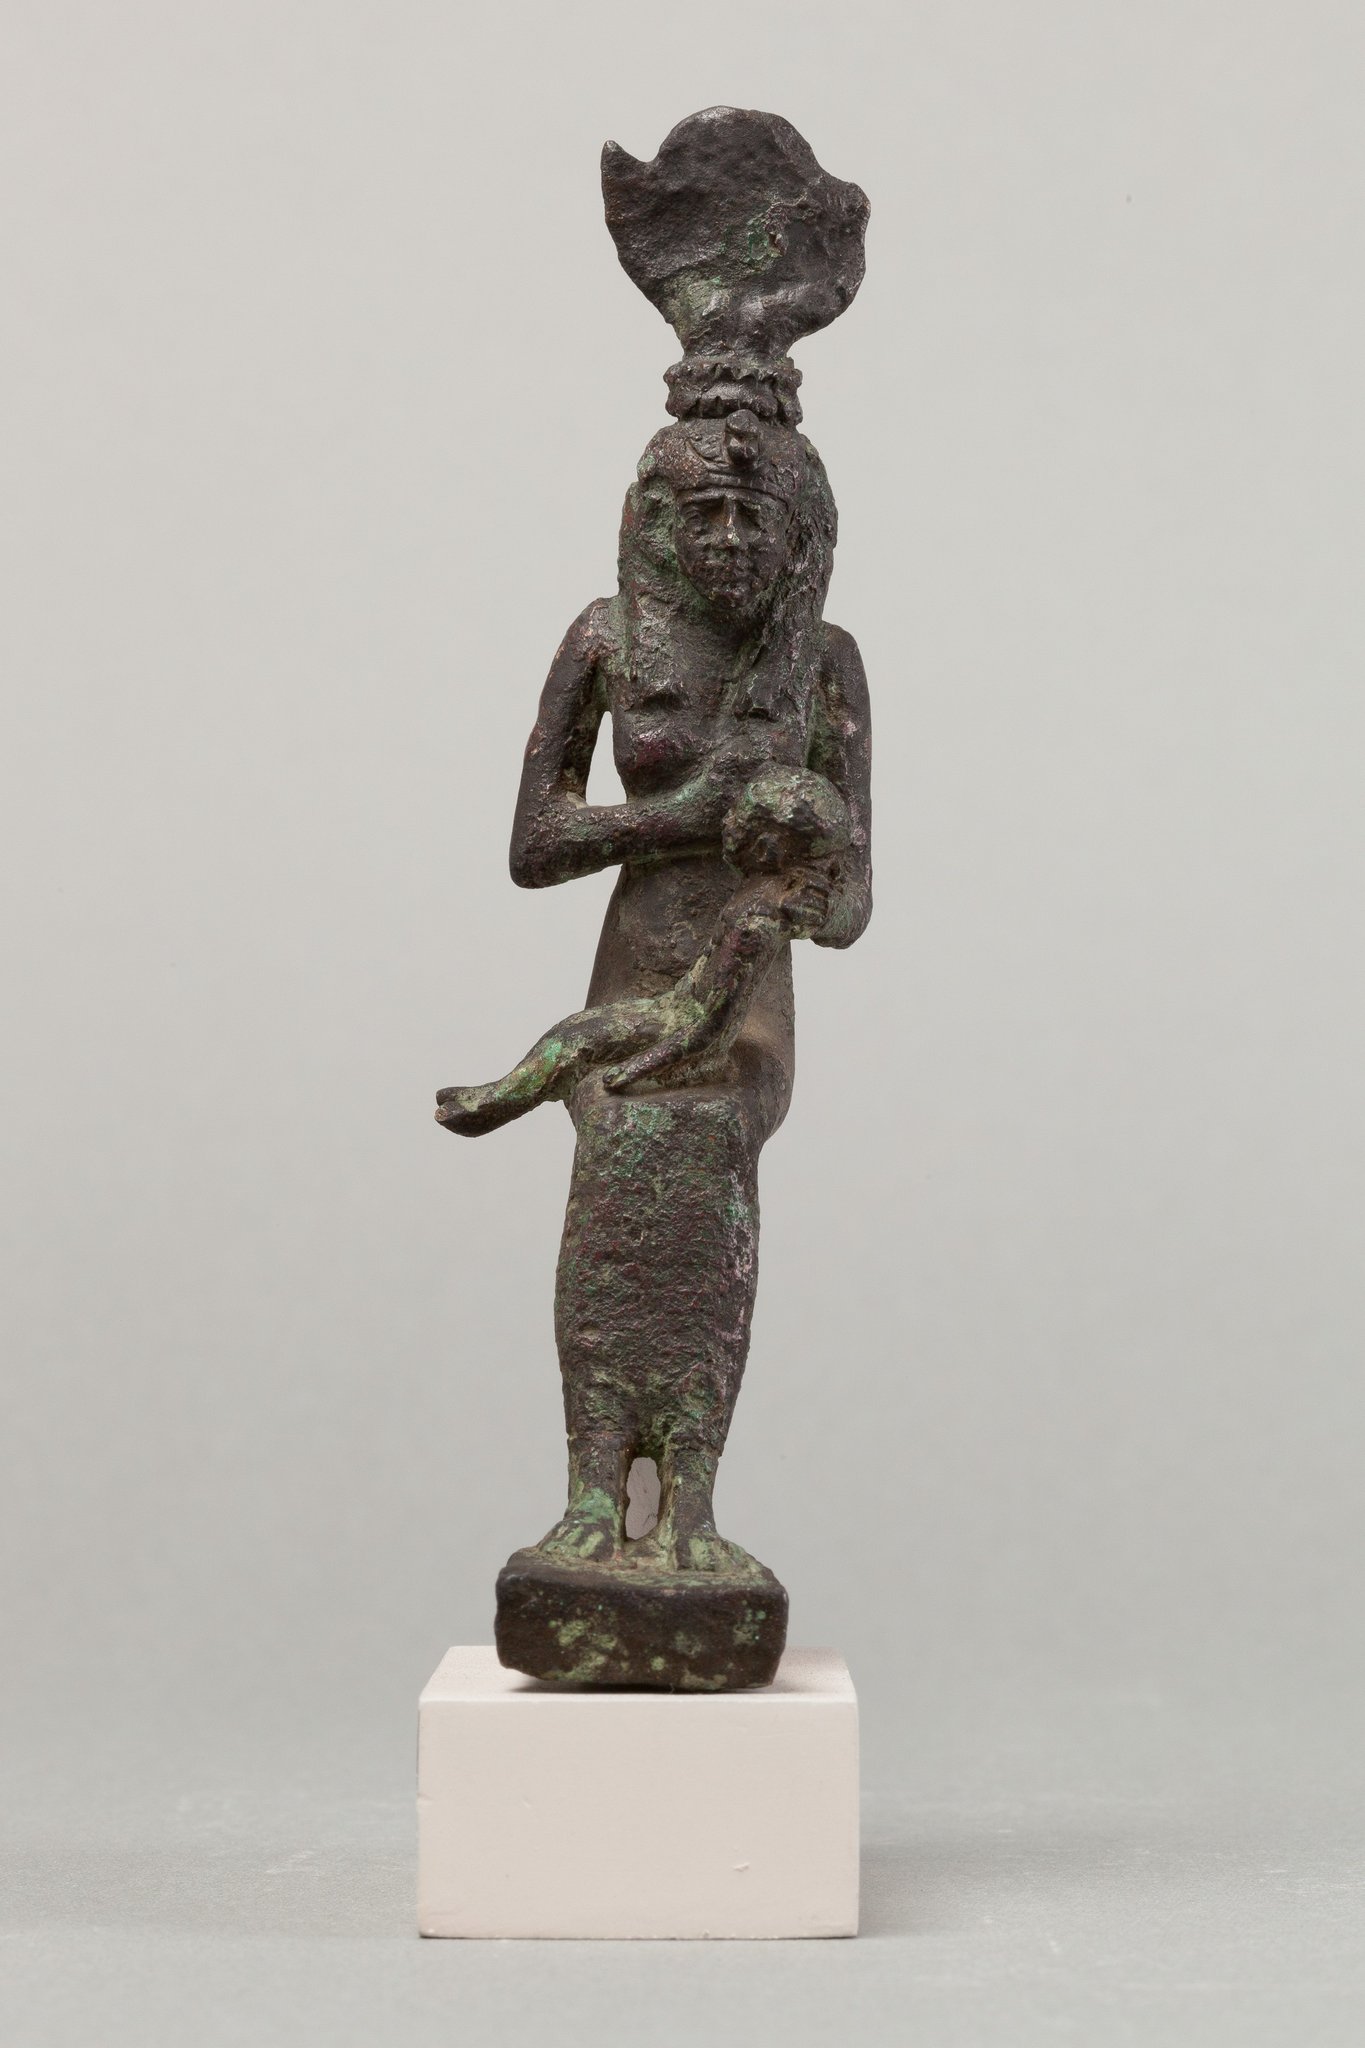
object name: statuette, isi, horus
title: Isis and Horus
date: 664-630 BCE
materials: metal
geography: egypt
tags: horus,isis,nursing